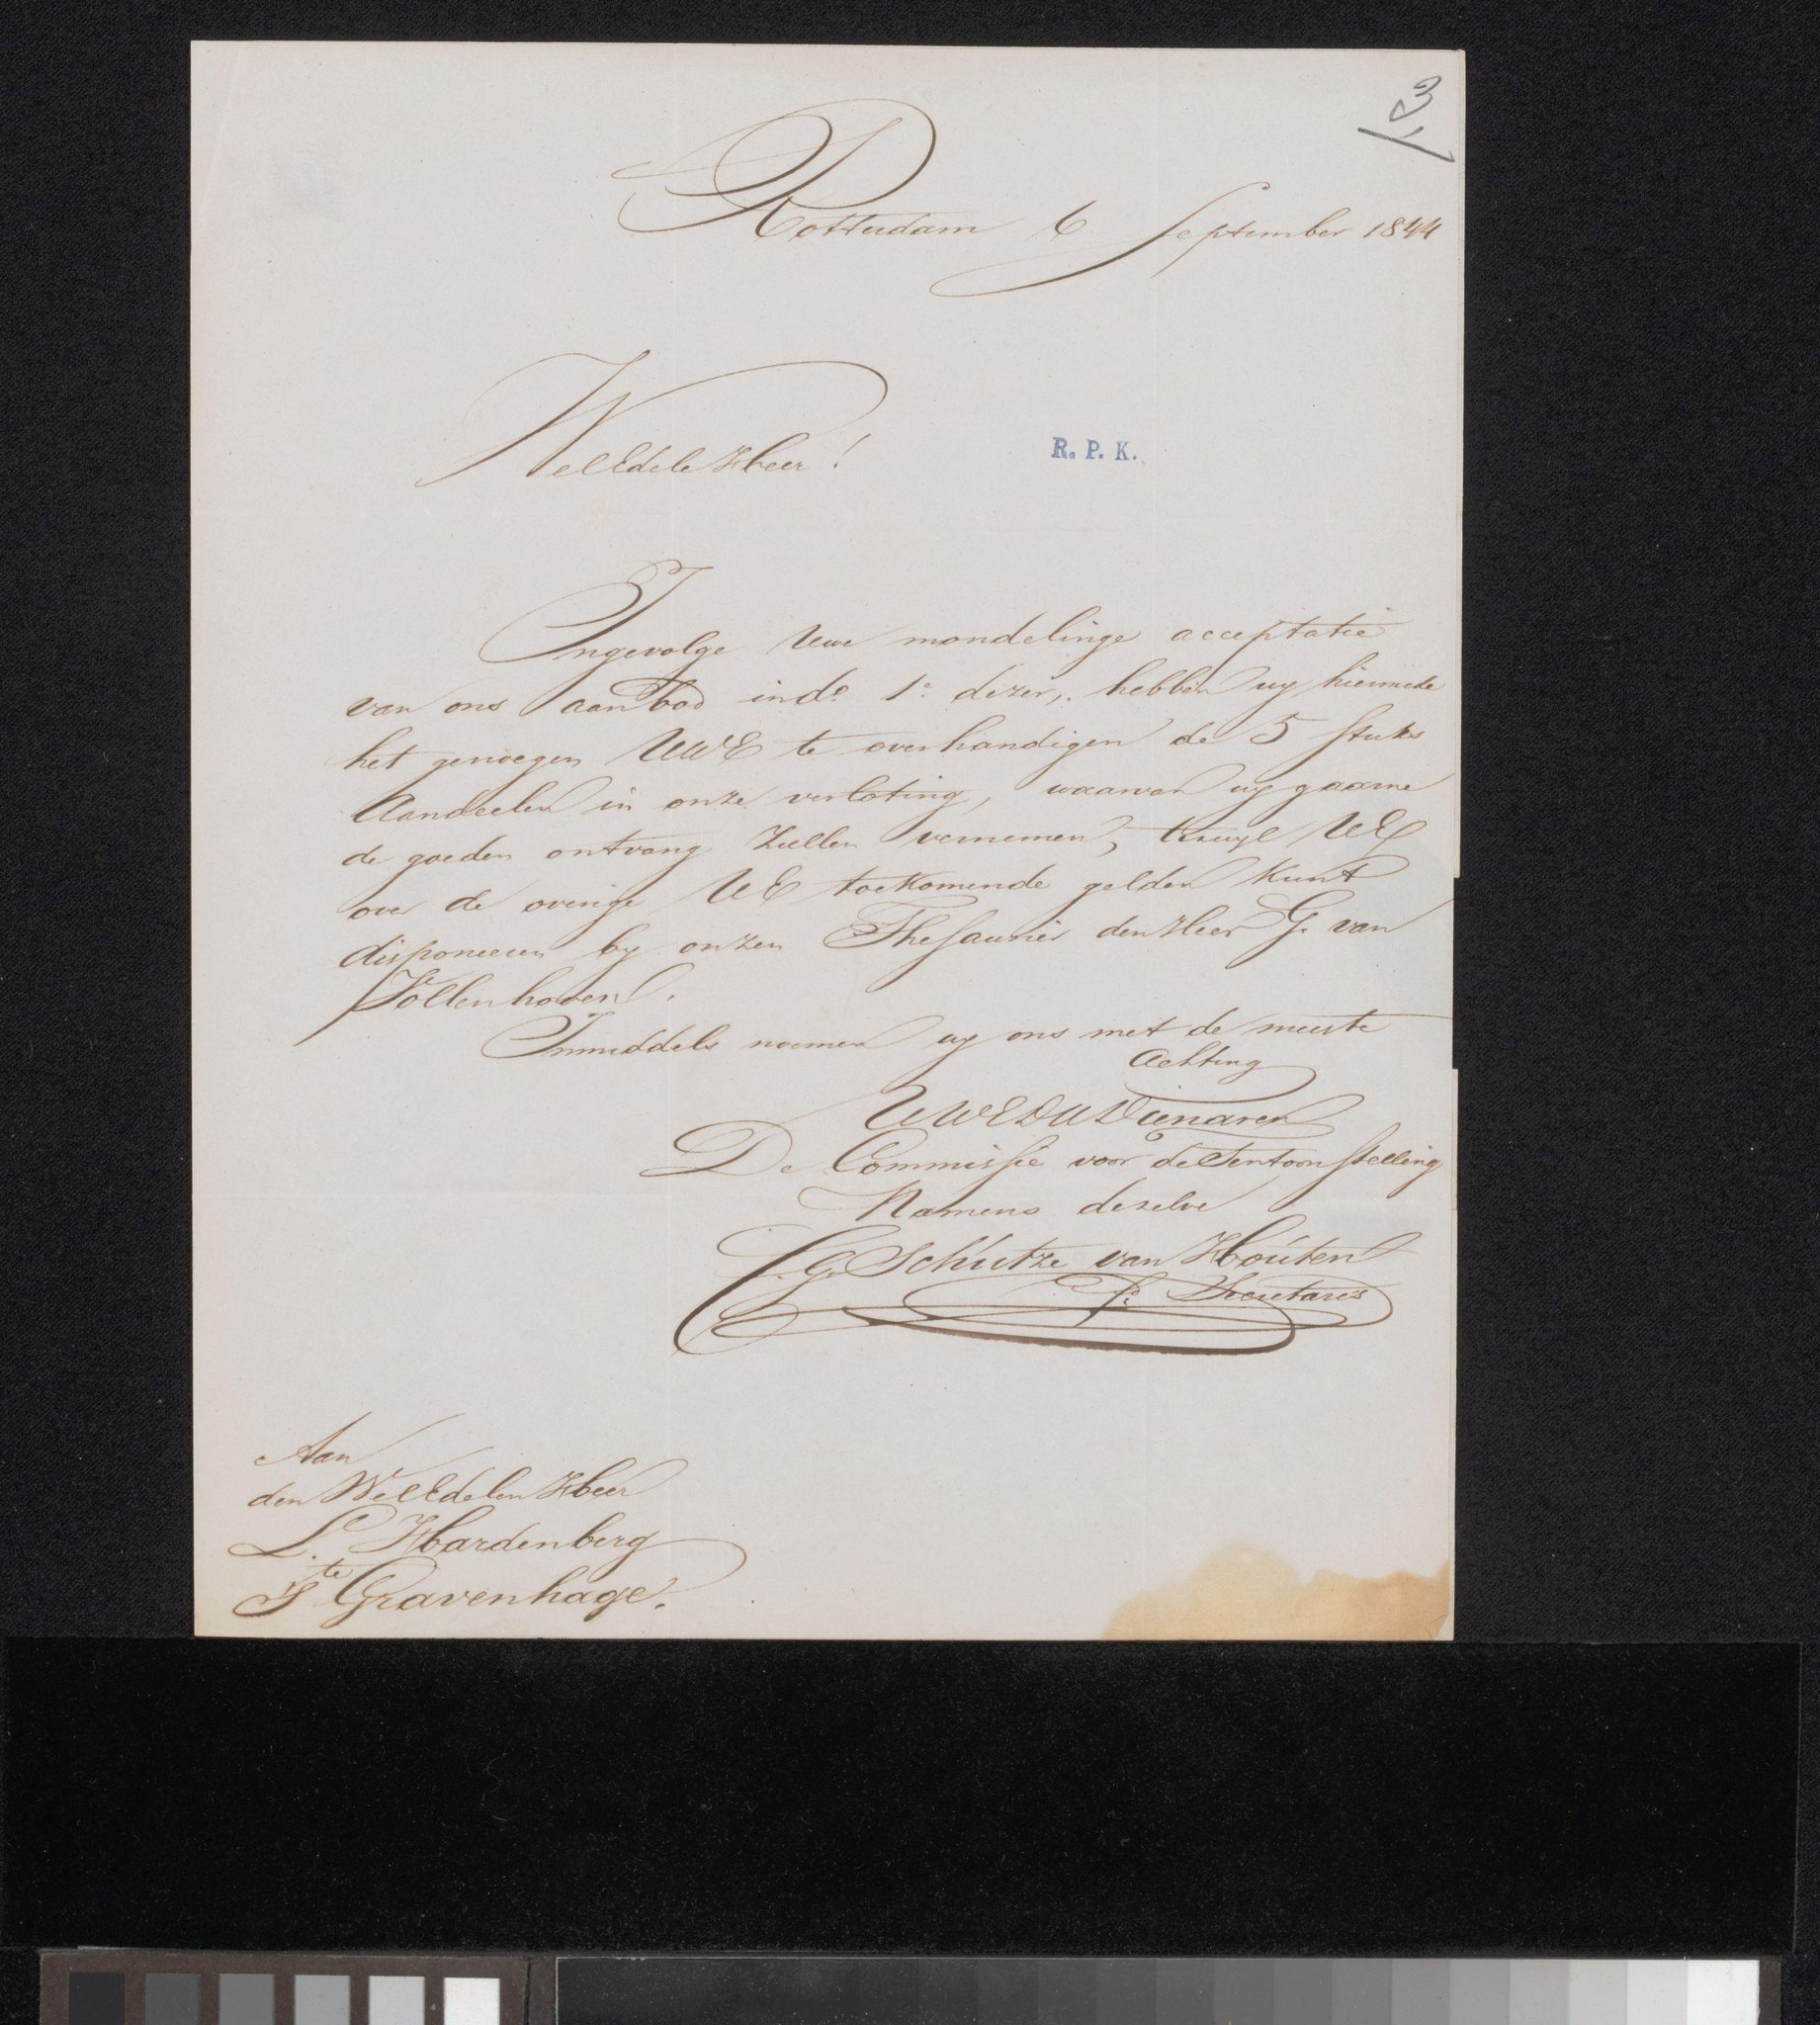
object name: letter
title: Brief aan Lambertus Hardenberg (1822-1900)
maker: christiaan godfried schutze van houten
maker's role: print maker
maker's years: 1807-1869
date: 1844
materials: ink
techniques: pen, writing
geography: rotterdam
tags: the hague, painter, draughtsman, lambertus hardenberg (1822-1900)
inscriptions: collector's mark: Lugt 2233